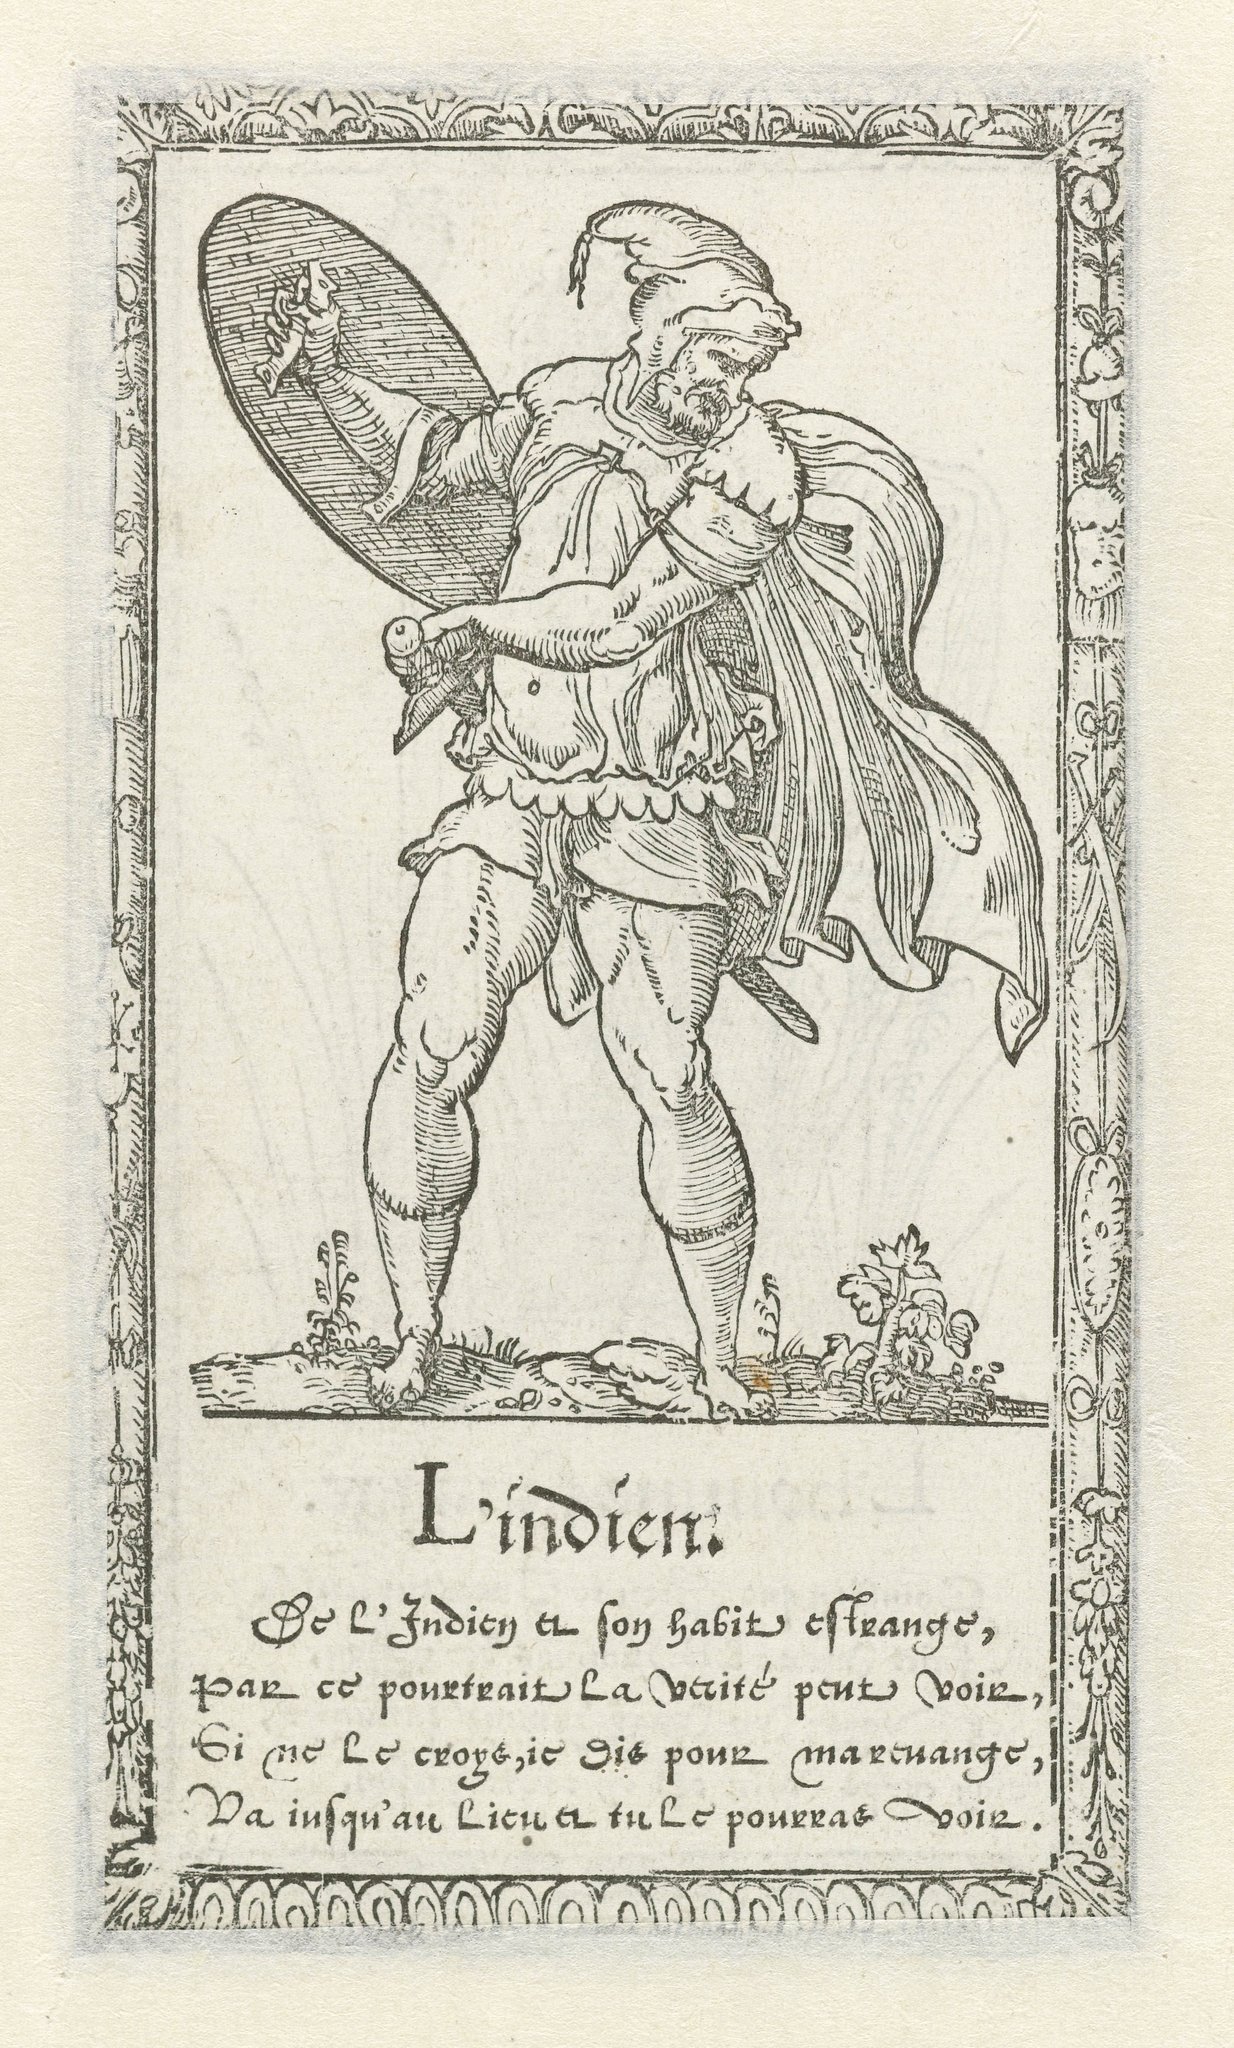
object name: print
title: Man uit India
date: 1562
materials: paper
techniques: woodcut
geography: venice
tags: fashion plates, human races; peoples; nationalities (+ costume), folk costume, regional costume, asiatic races and peoples: indians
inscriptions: collector's mark: Lugt 2228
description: Dit is prent 94 uit een serie van 121. Binnen deze serie zijn er prenten gemaakt naar voorbeelden van Jean-François de Roberval en Enea Vico, onbekend welke precies.